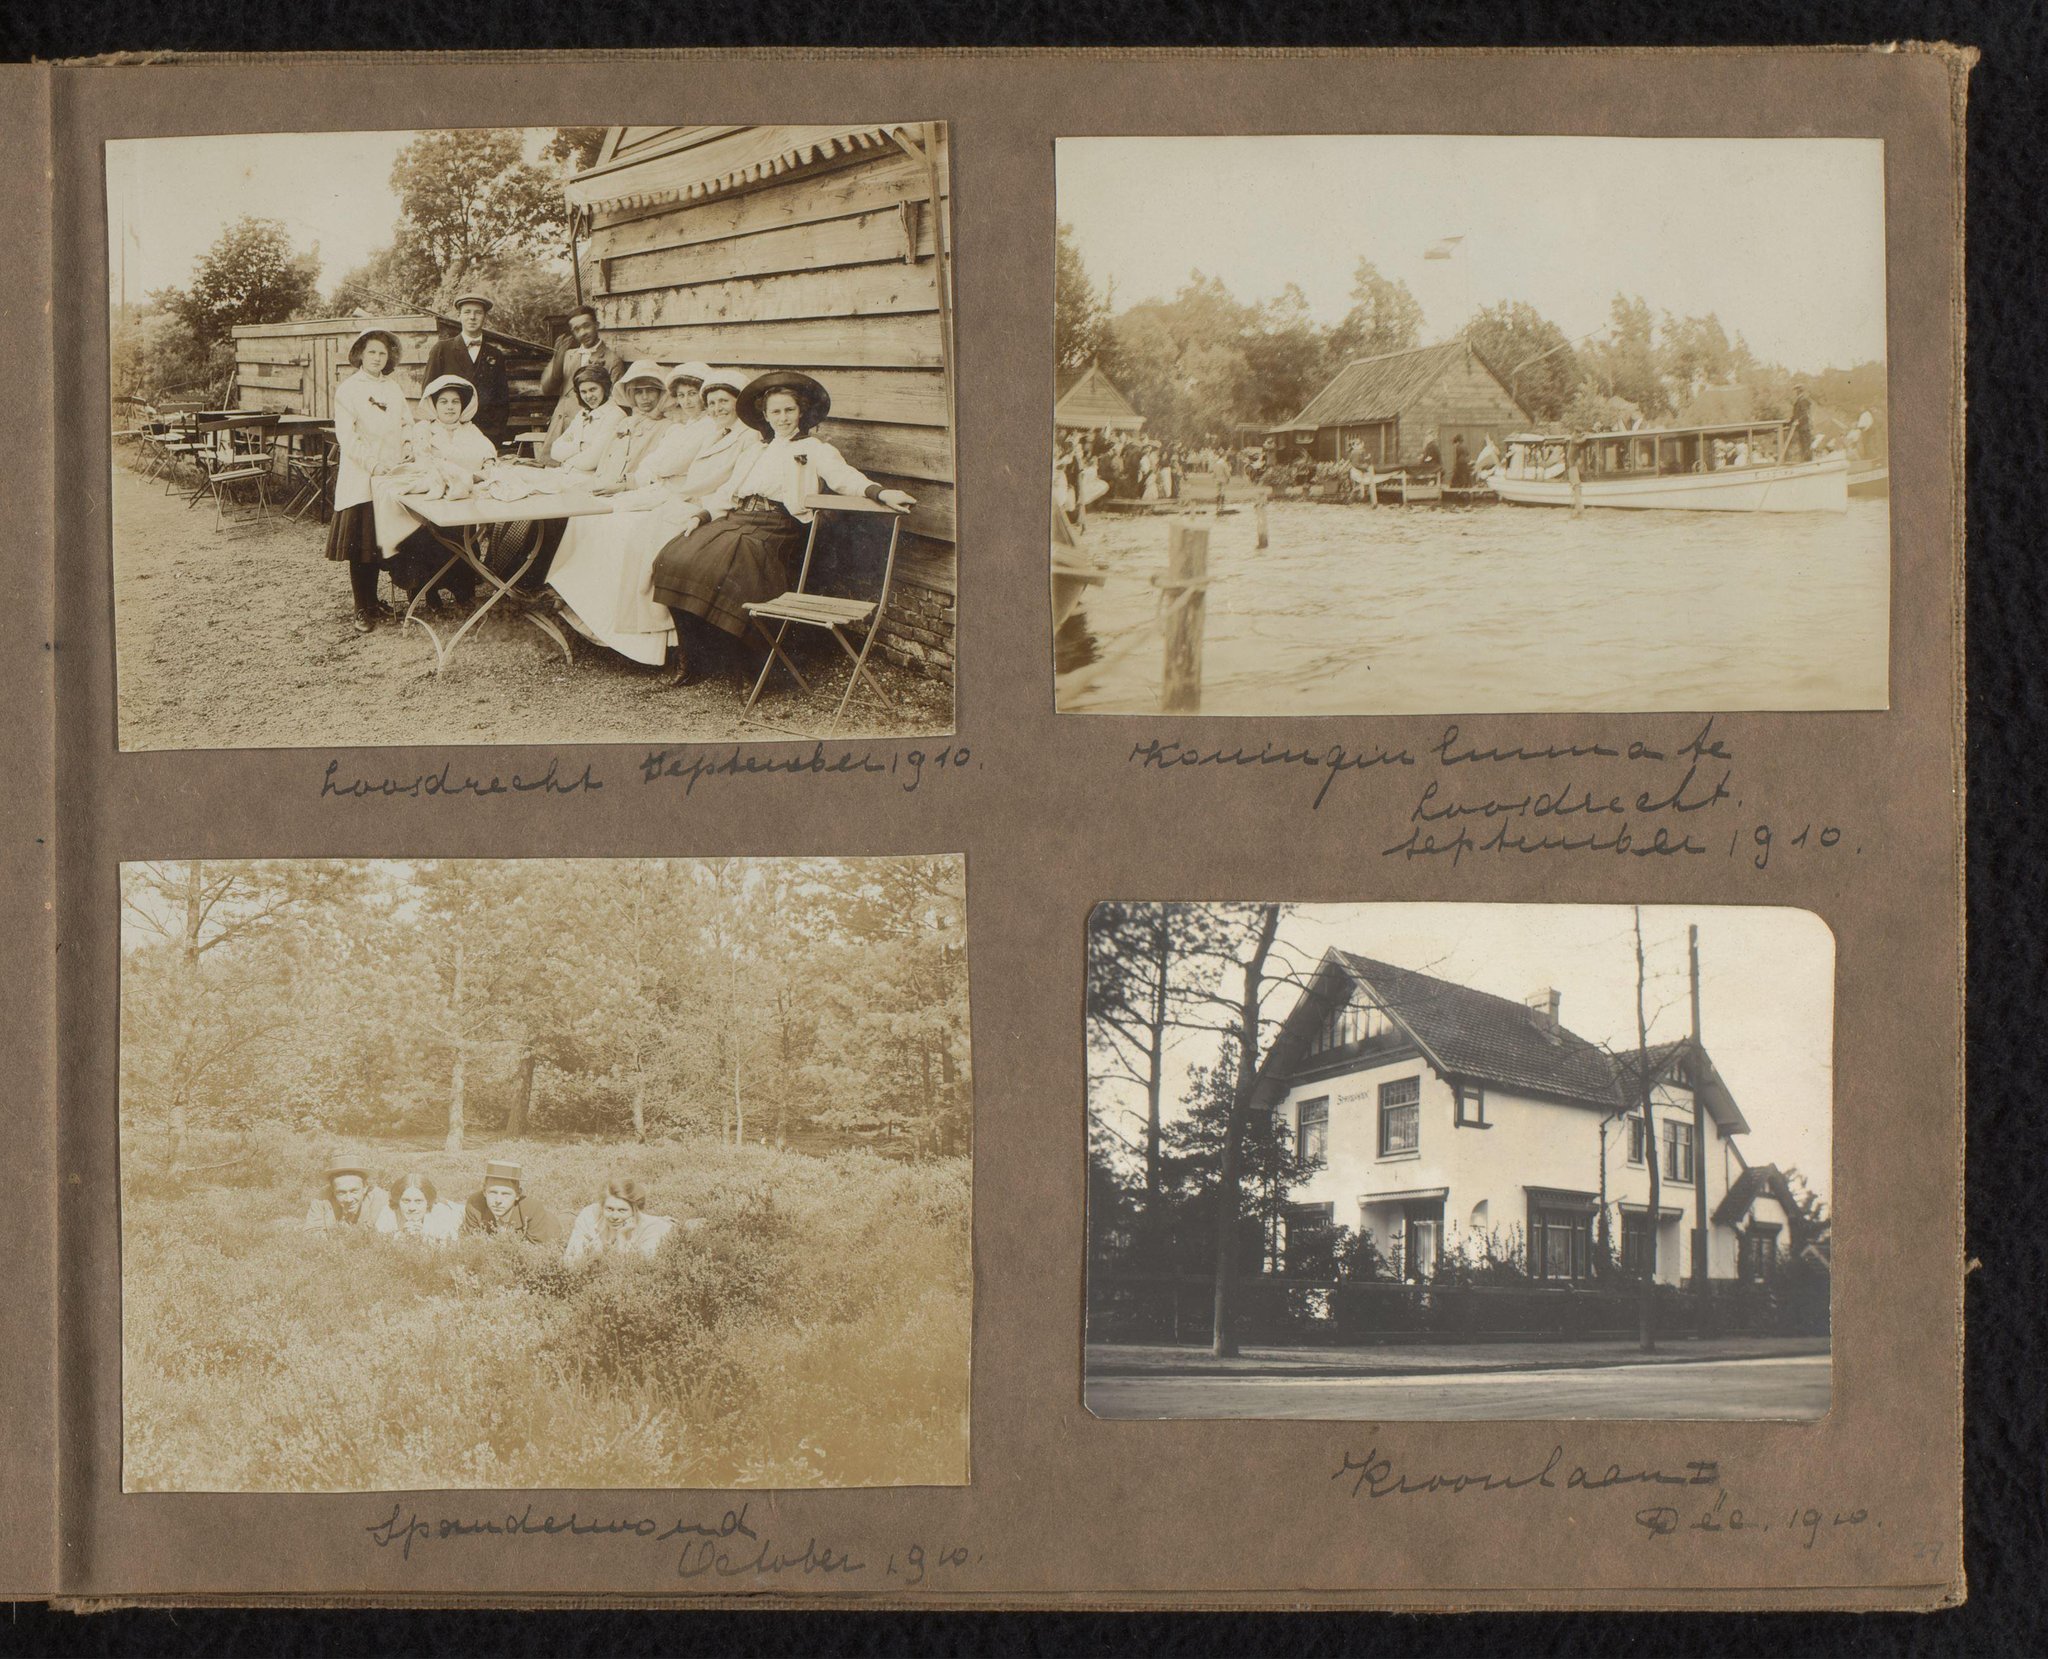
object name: photograph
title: Vier foto's van Loentje Onnen met vrienden in Loosdrecht en het Spanderswoud, koningin-moeder Emma te Loosdrecht en huis Sparrenhoek aan de Kroonlaan te Hilversum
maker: carolina frederika onnen (lien/loen)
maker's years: 1896-1983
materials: paper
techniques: gelatin silver print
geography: netherlands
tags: the hague, emma (queen consort of the netherlands), amsterdam, carolina frederika onnen (lien/loen), lake, pavement, terrace in front of inn or restaurant, villa, friends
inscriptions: inscription: ‘Kroonlaan I/ Dec. 1910’, inscription: ‘Loosdrecht September 1910’, inscription: ‘Koningin Emma te/ Loosdrecht/ september 1910’, inscription: ‘Spanderswoud/ October 1910’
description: Deze foto's maken deel uit van een album.